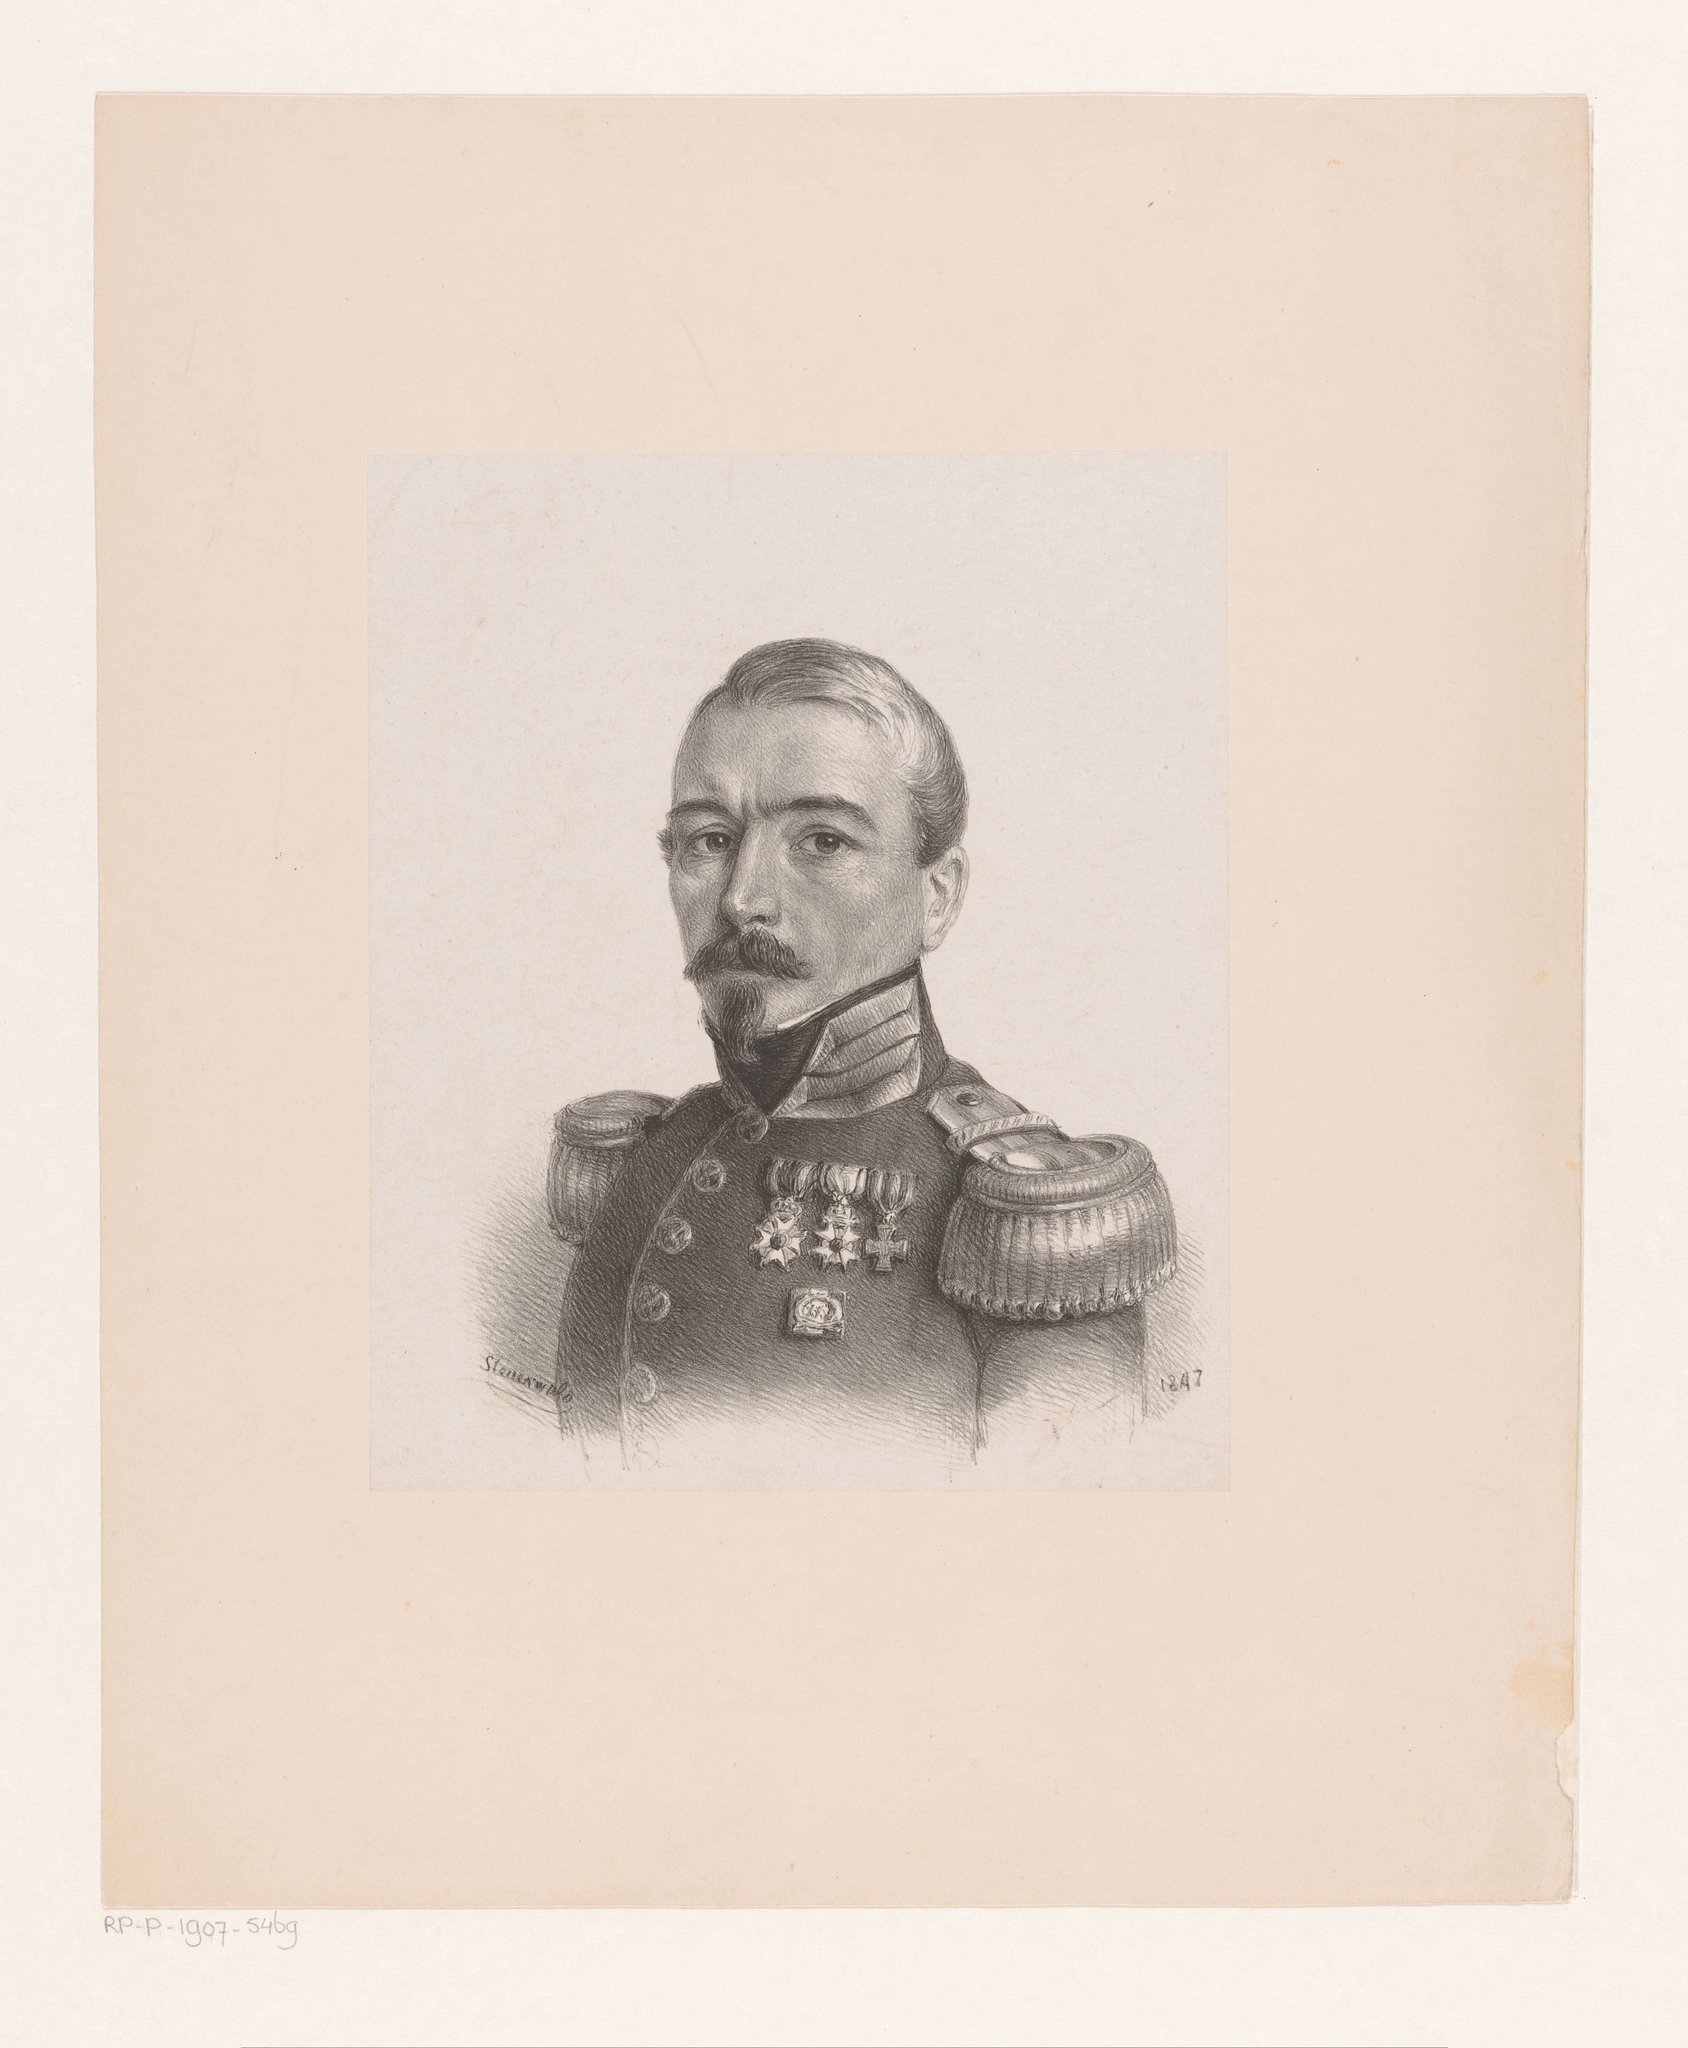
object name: print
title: Zelfportret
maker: christian heinrich gottlieb steuerwald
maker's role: draughtsman, print maker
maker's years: 1802-1874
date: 1847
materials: paper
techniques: lithograph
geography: dordrecht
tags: draughtsman, christian heinrich gottlieb steuerwald, historical persons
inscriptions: collector's mark: Lugt 2228